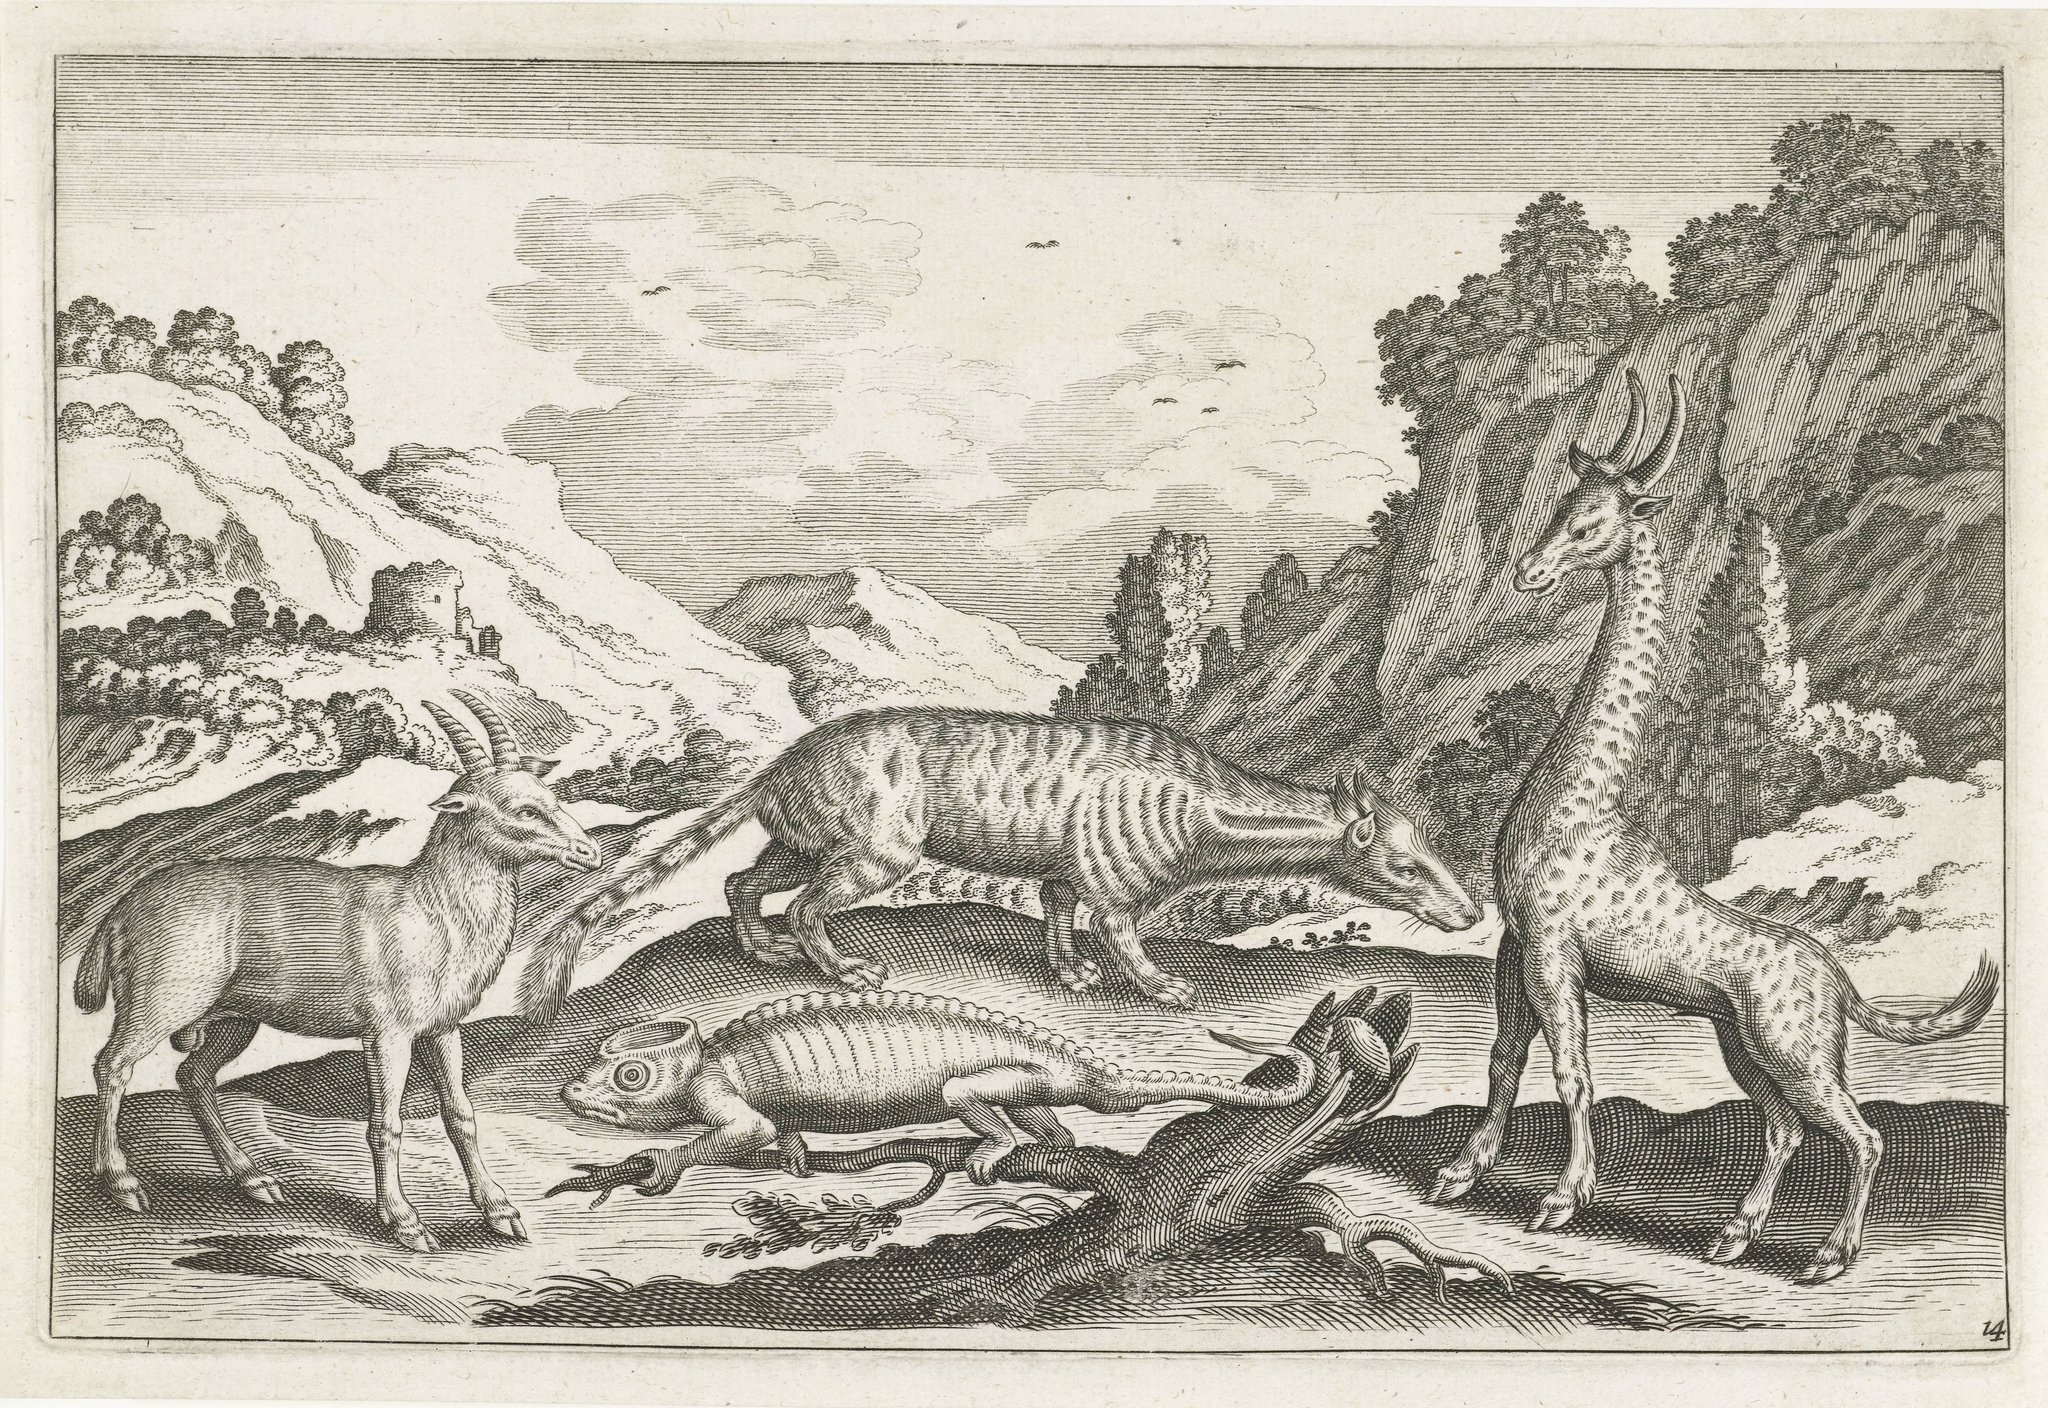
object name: print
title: Exotische dieren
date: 1628-1679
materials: paper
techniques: engraving, etching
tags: hoofed animals: giraffe, lizards: chameleon, beasts of prey, predatory animals: civet, hoofed animals: antelope, mountains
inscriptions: collector's mark: Lugt 2228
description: Op de voorgrond een giraf, een kameleon, een civetkat en een antilope. Op de achtergrond een berglandschap. De prent maakt deel uit van een serie met als onderwerp dieren.